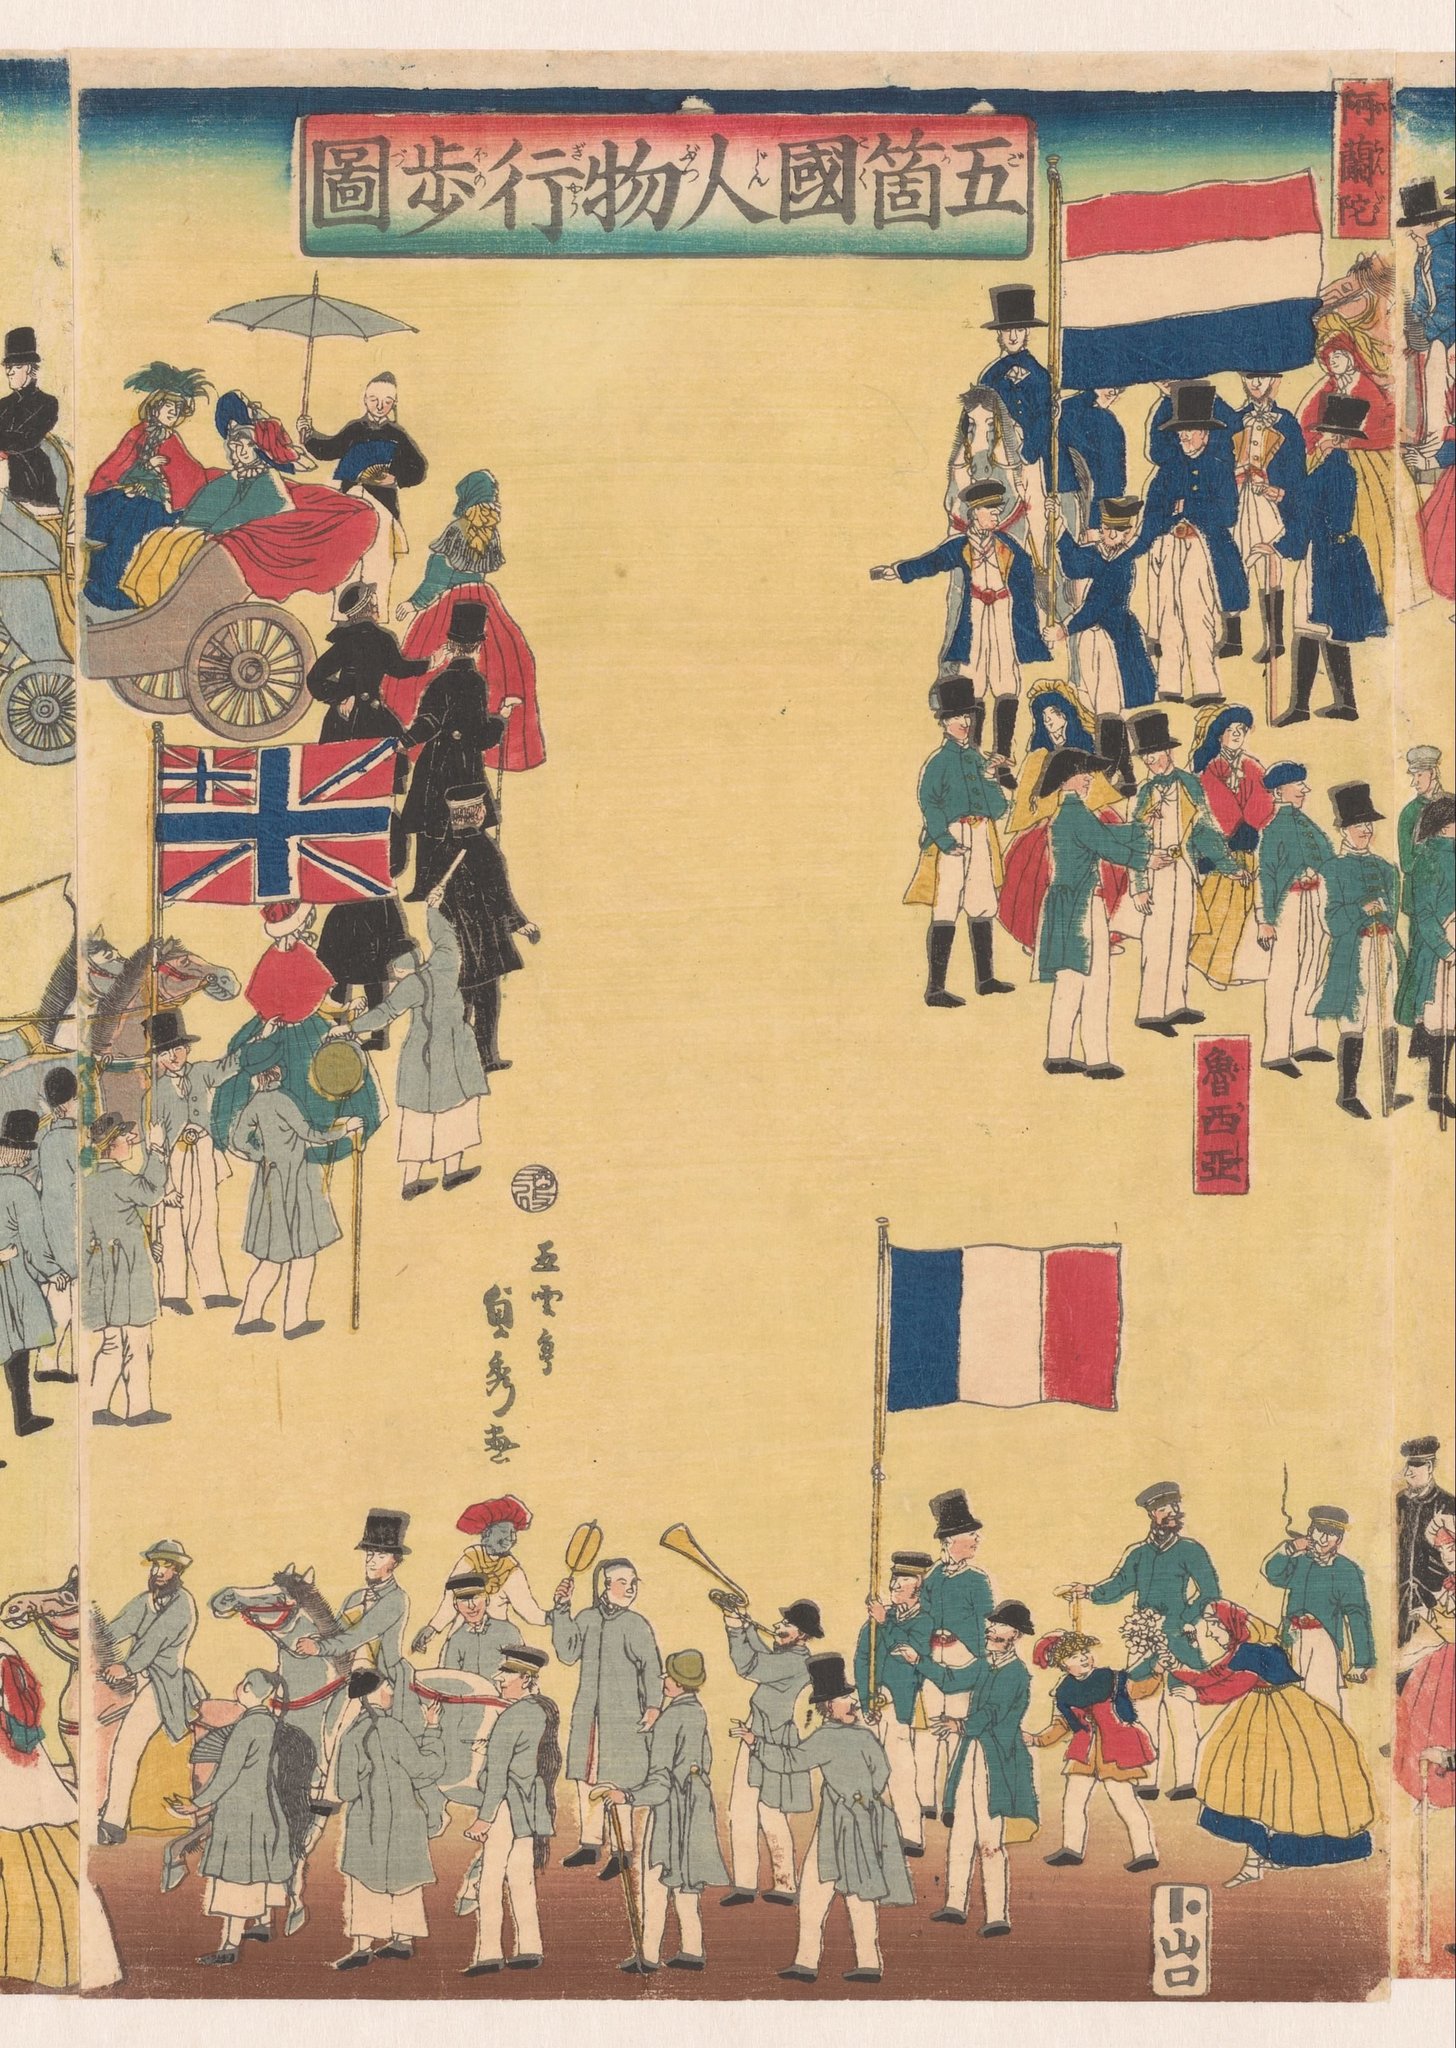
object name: print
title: Optocht van mensen uit de Vijf Landen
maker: utagawa sadahide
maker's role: draughtsman, print maker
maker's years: 1807-1873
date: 1803-1861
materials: paper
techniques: woodcut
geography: japan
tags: folk costume, regional costume, festivities on events of national importance, human races; peoples; nationalities